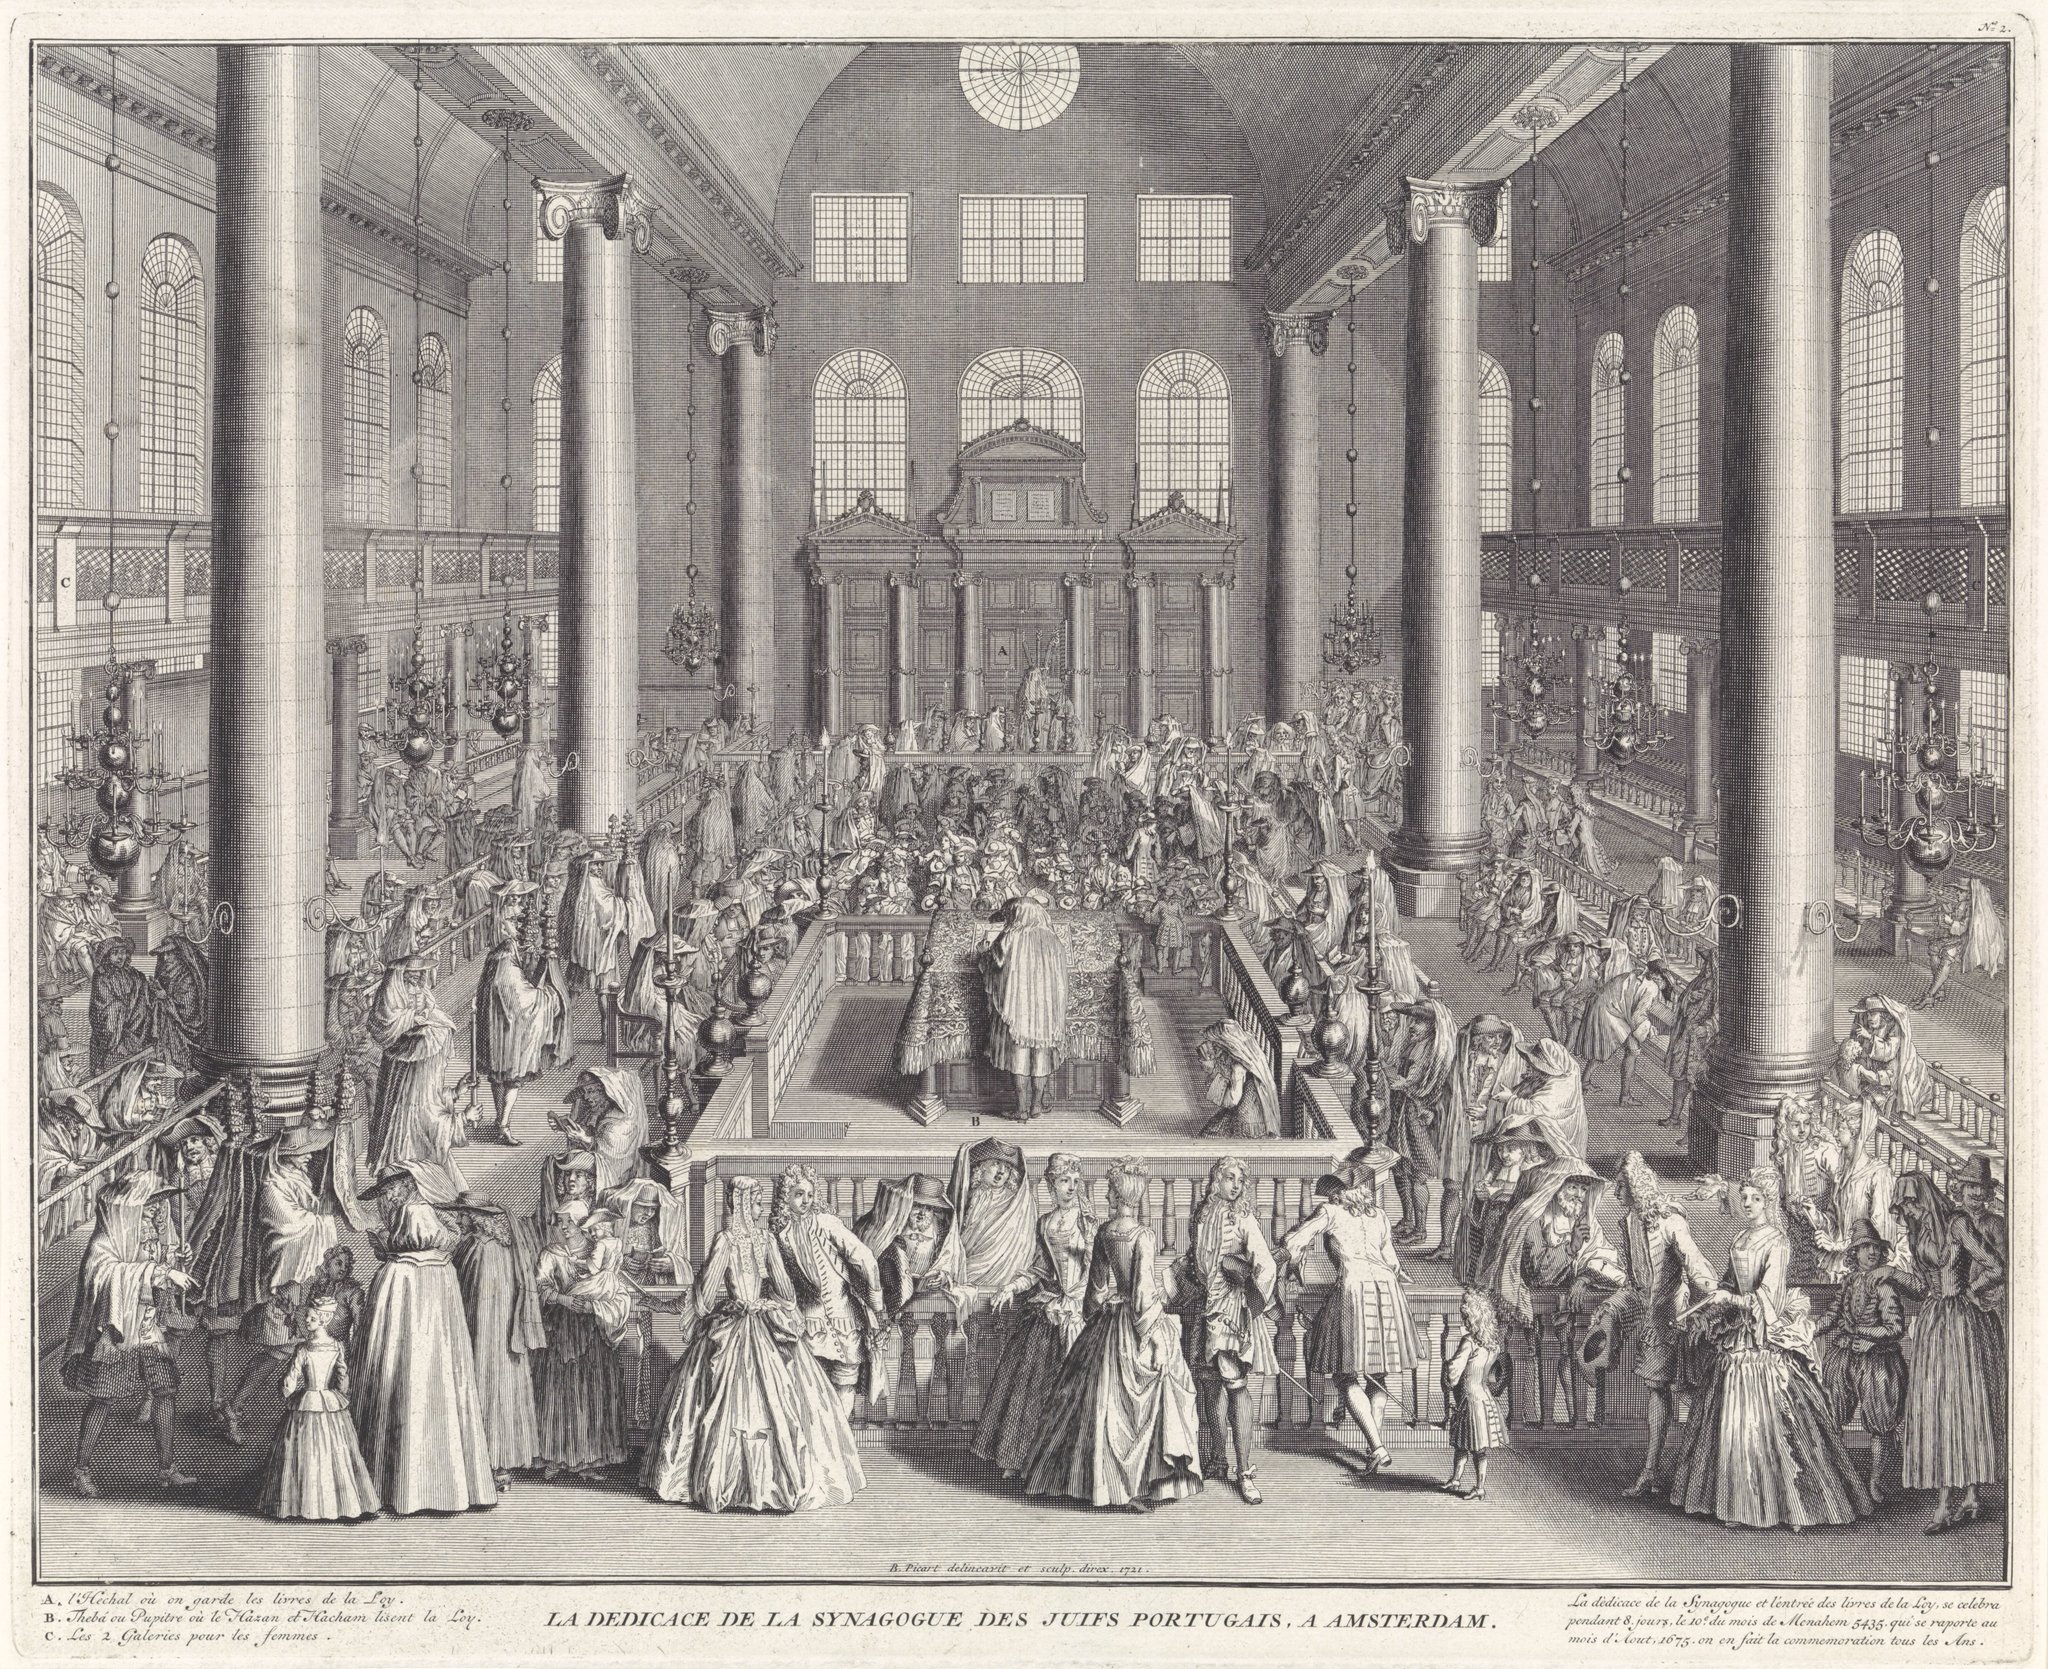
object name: print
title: La dedicace de la synagogue des Juifs Portugais, a Amsterdam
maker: bernard picart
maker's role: draughtsman, print maker, publisher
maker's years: 1673-1733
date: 1721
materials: paper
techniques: engraving, etching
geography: amsterdam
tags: the synagogue (as building and place of worship ~ jewish religion)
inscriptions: collector's mark: Lugt 2233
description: De feestelijke inwijding van de Portugese Synagoge te Amsterdam op 2 augustus 1675. Op het podium in het midden staat de chazan, de voorzanger, om voor te lezen uit de Thora. Op de achtergrond de hechal, de kast, waarin de Thorarollen worden bewaard. Onderaan in de marge een legenda en een toelichting in het Frans.